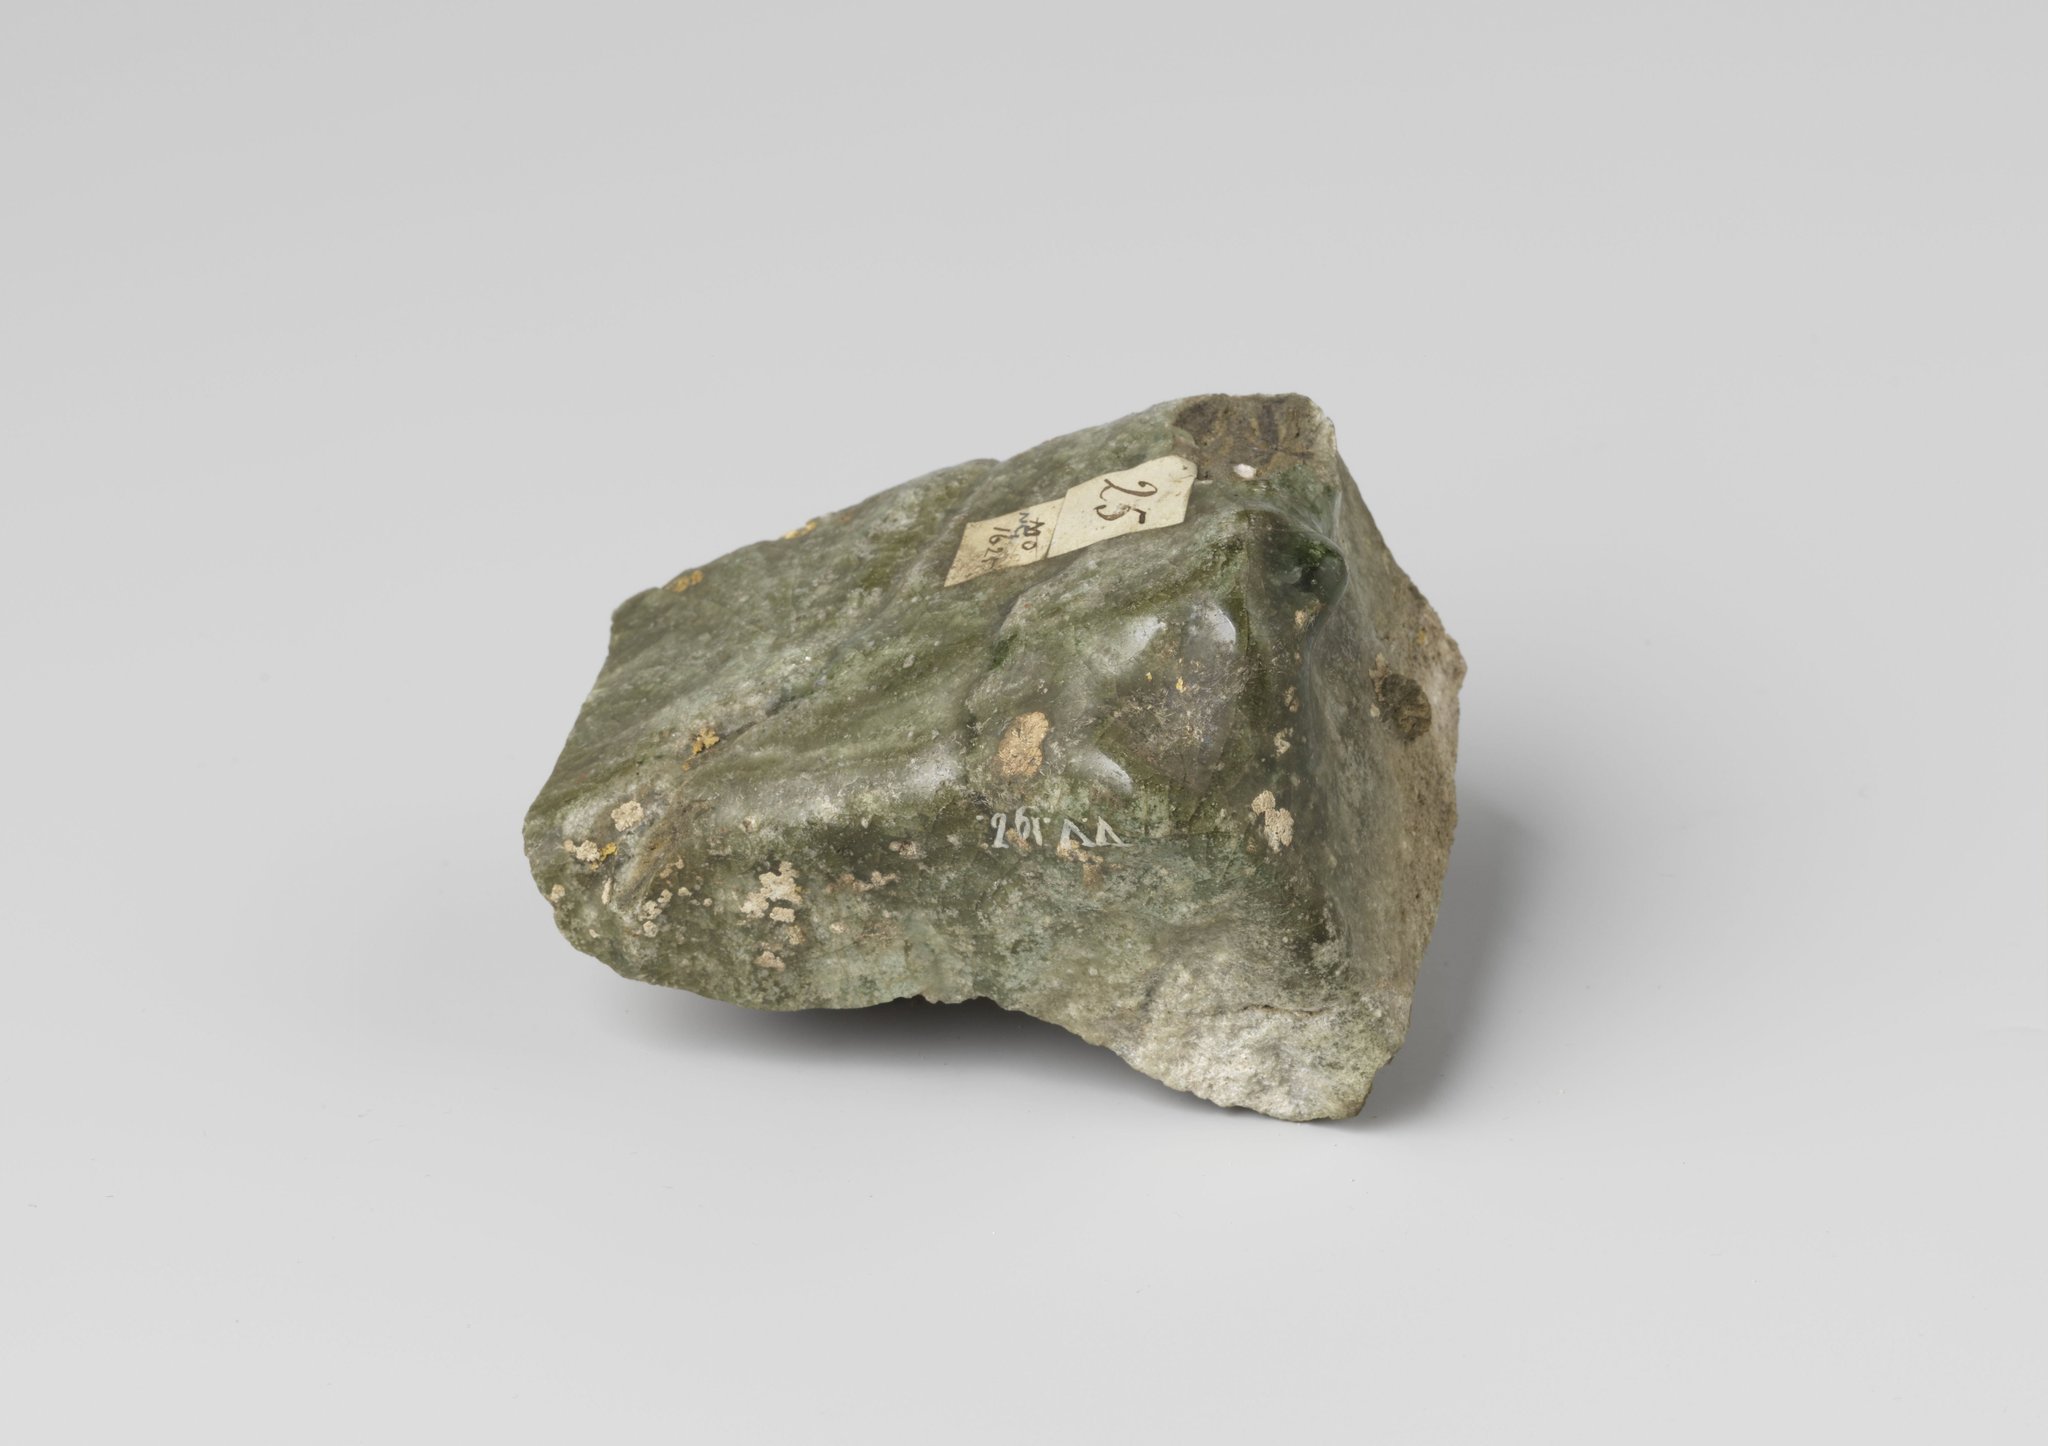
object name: brick clay product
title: Een stuk van een baksteen, gedeeltelijk verglaasd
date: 1421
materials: brick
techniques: firing, painted, vitrification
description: Ruw stuk baksteen, aan drie vlakke kanten verglaasd en groen van kleur, aan een vierde vlakke kant zit nog een stuk cement. Daar zitten ook kleine oranje vlekjes van organisch materiaal (vroeger mos?). Verder onregelmatig van vorm. Opschrift: op etiket: 25 met witte verf: V.V,19b.